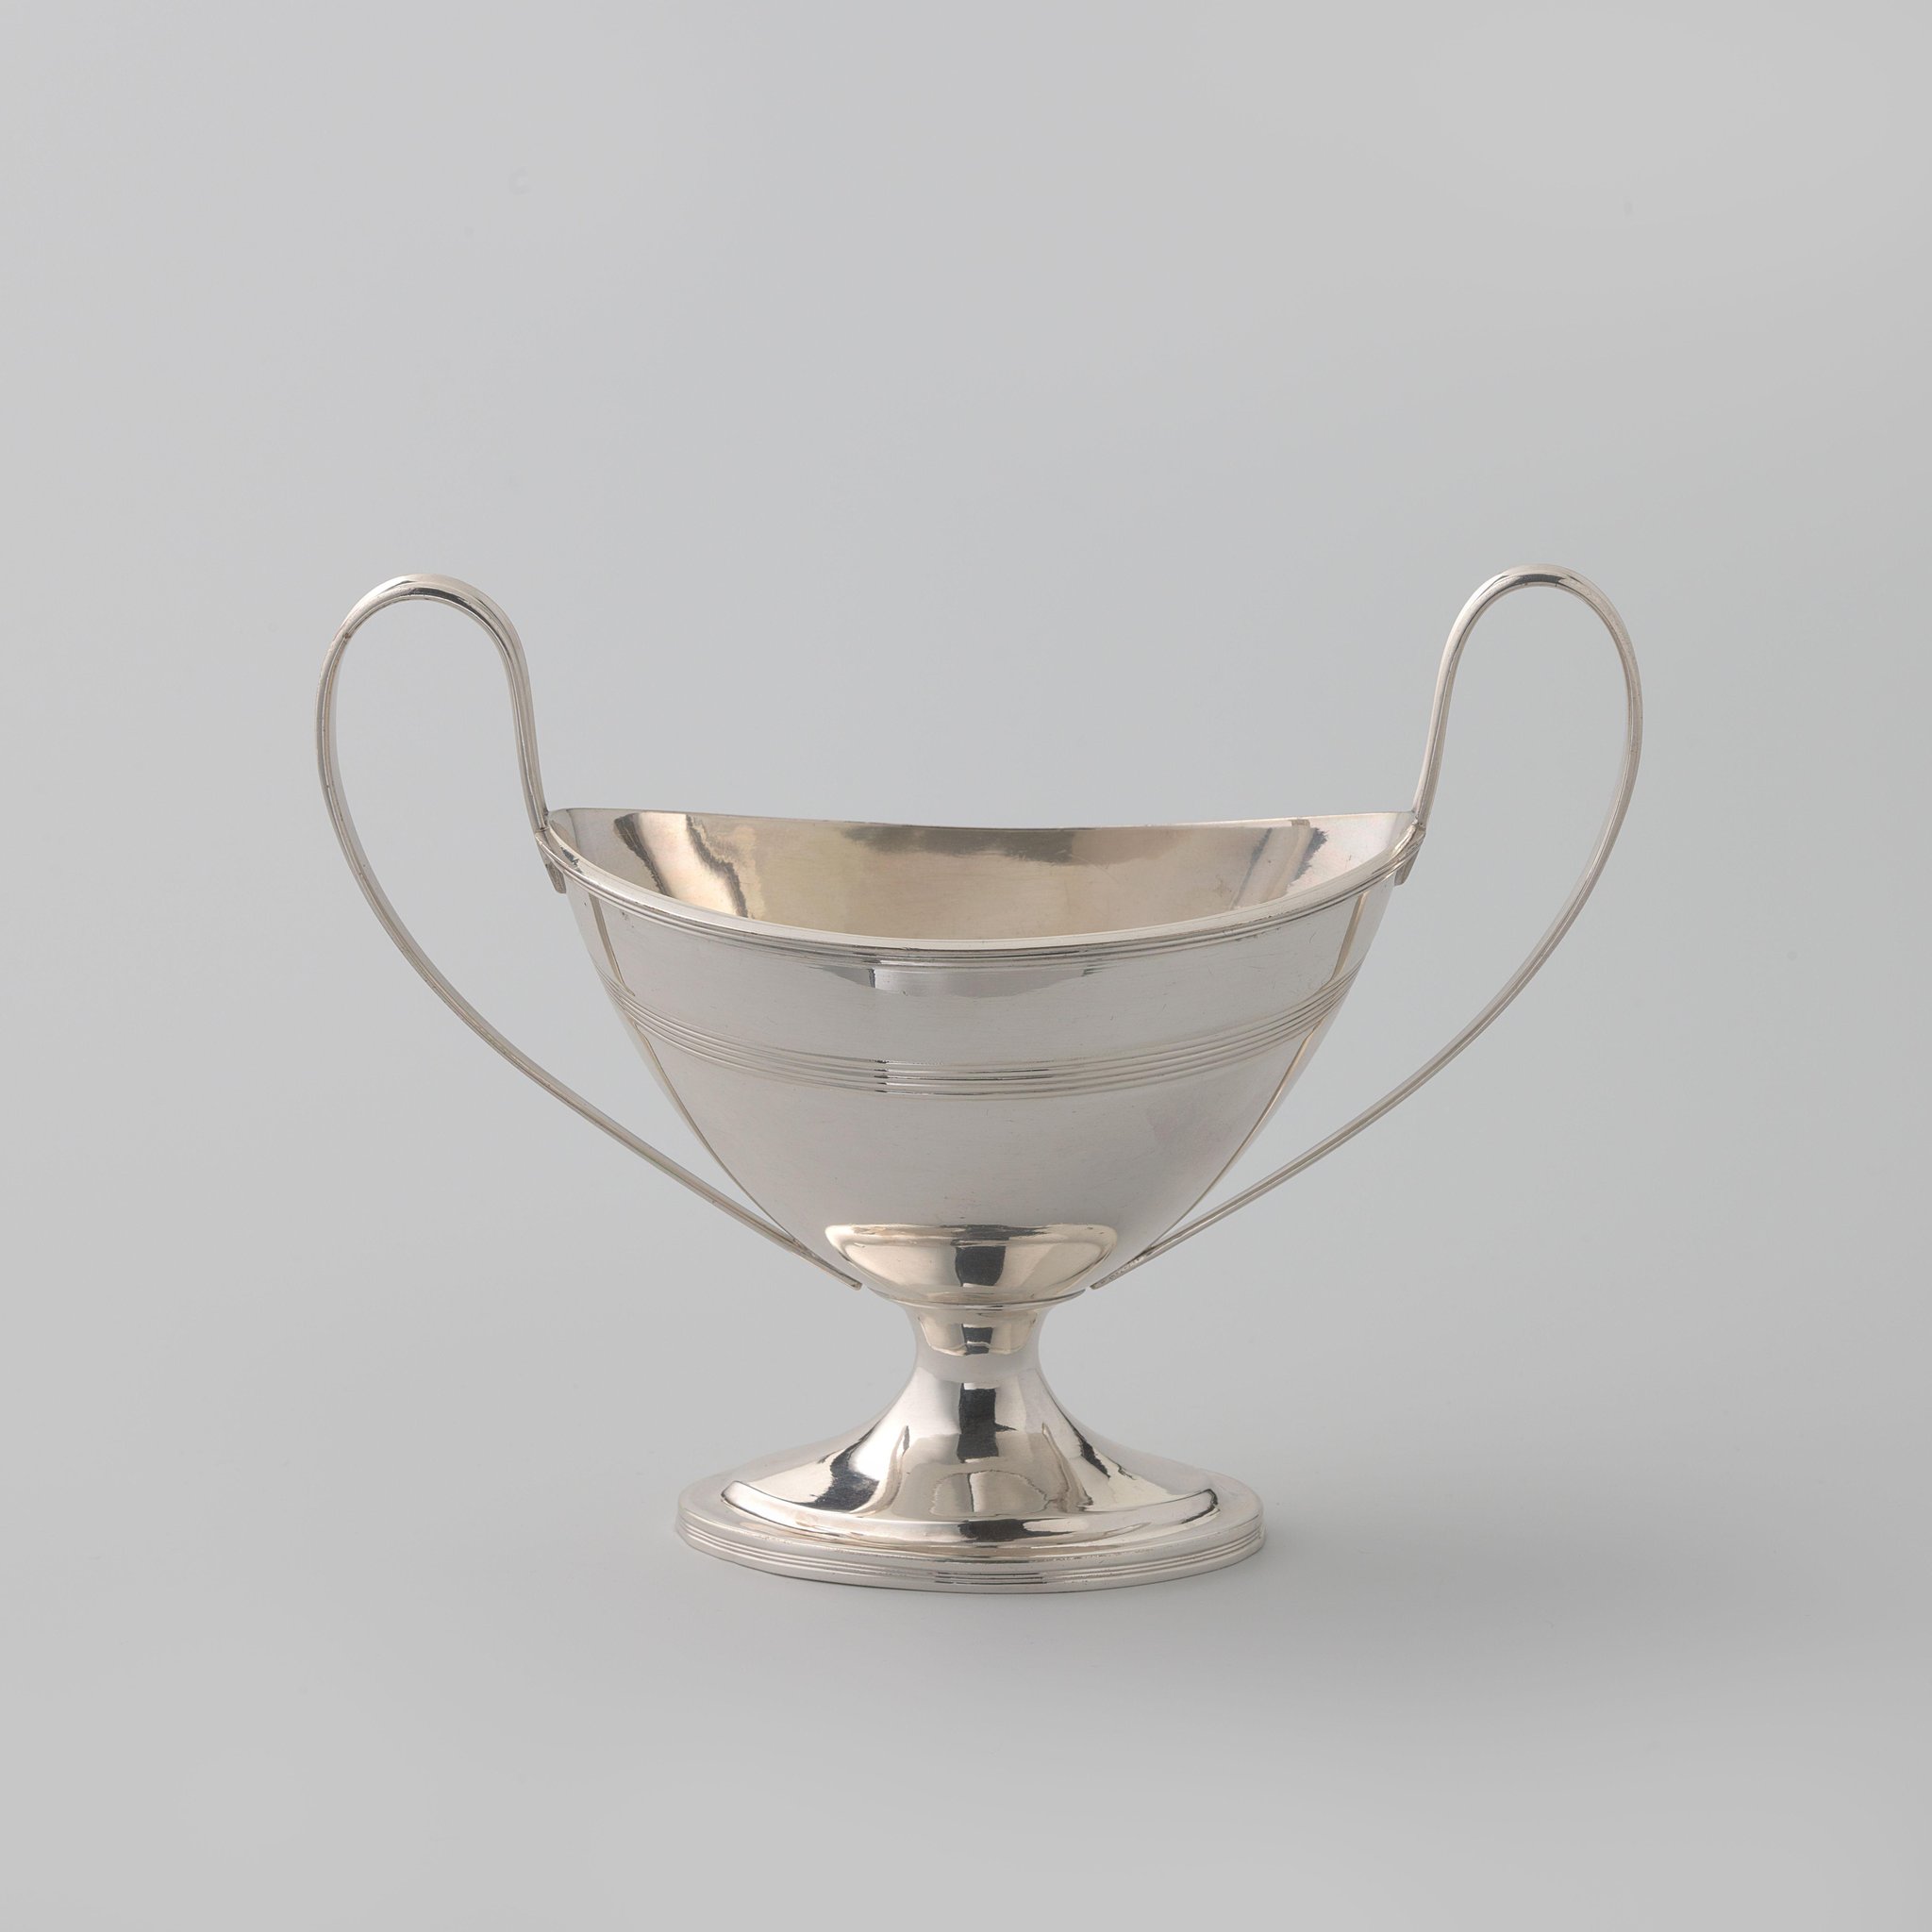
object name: suikervaas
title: Suikervaas van zilver, ovaal op gewelfde voet en met twee hoge oren. Versierd met filetranden.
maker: johannes adrianus van der toorn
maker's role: silversmith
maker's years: 1775-1849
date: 1815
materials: silver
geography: the hague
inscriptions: mark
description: Ovale suikervaas van zilver, op een gewelfde voet. Het zich verbredende lichaam is op 2/3 van de hoogte en langs de bovenzijde versierd emt filtranden. De vaas heeft 2 hoge oren.